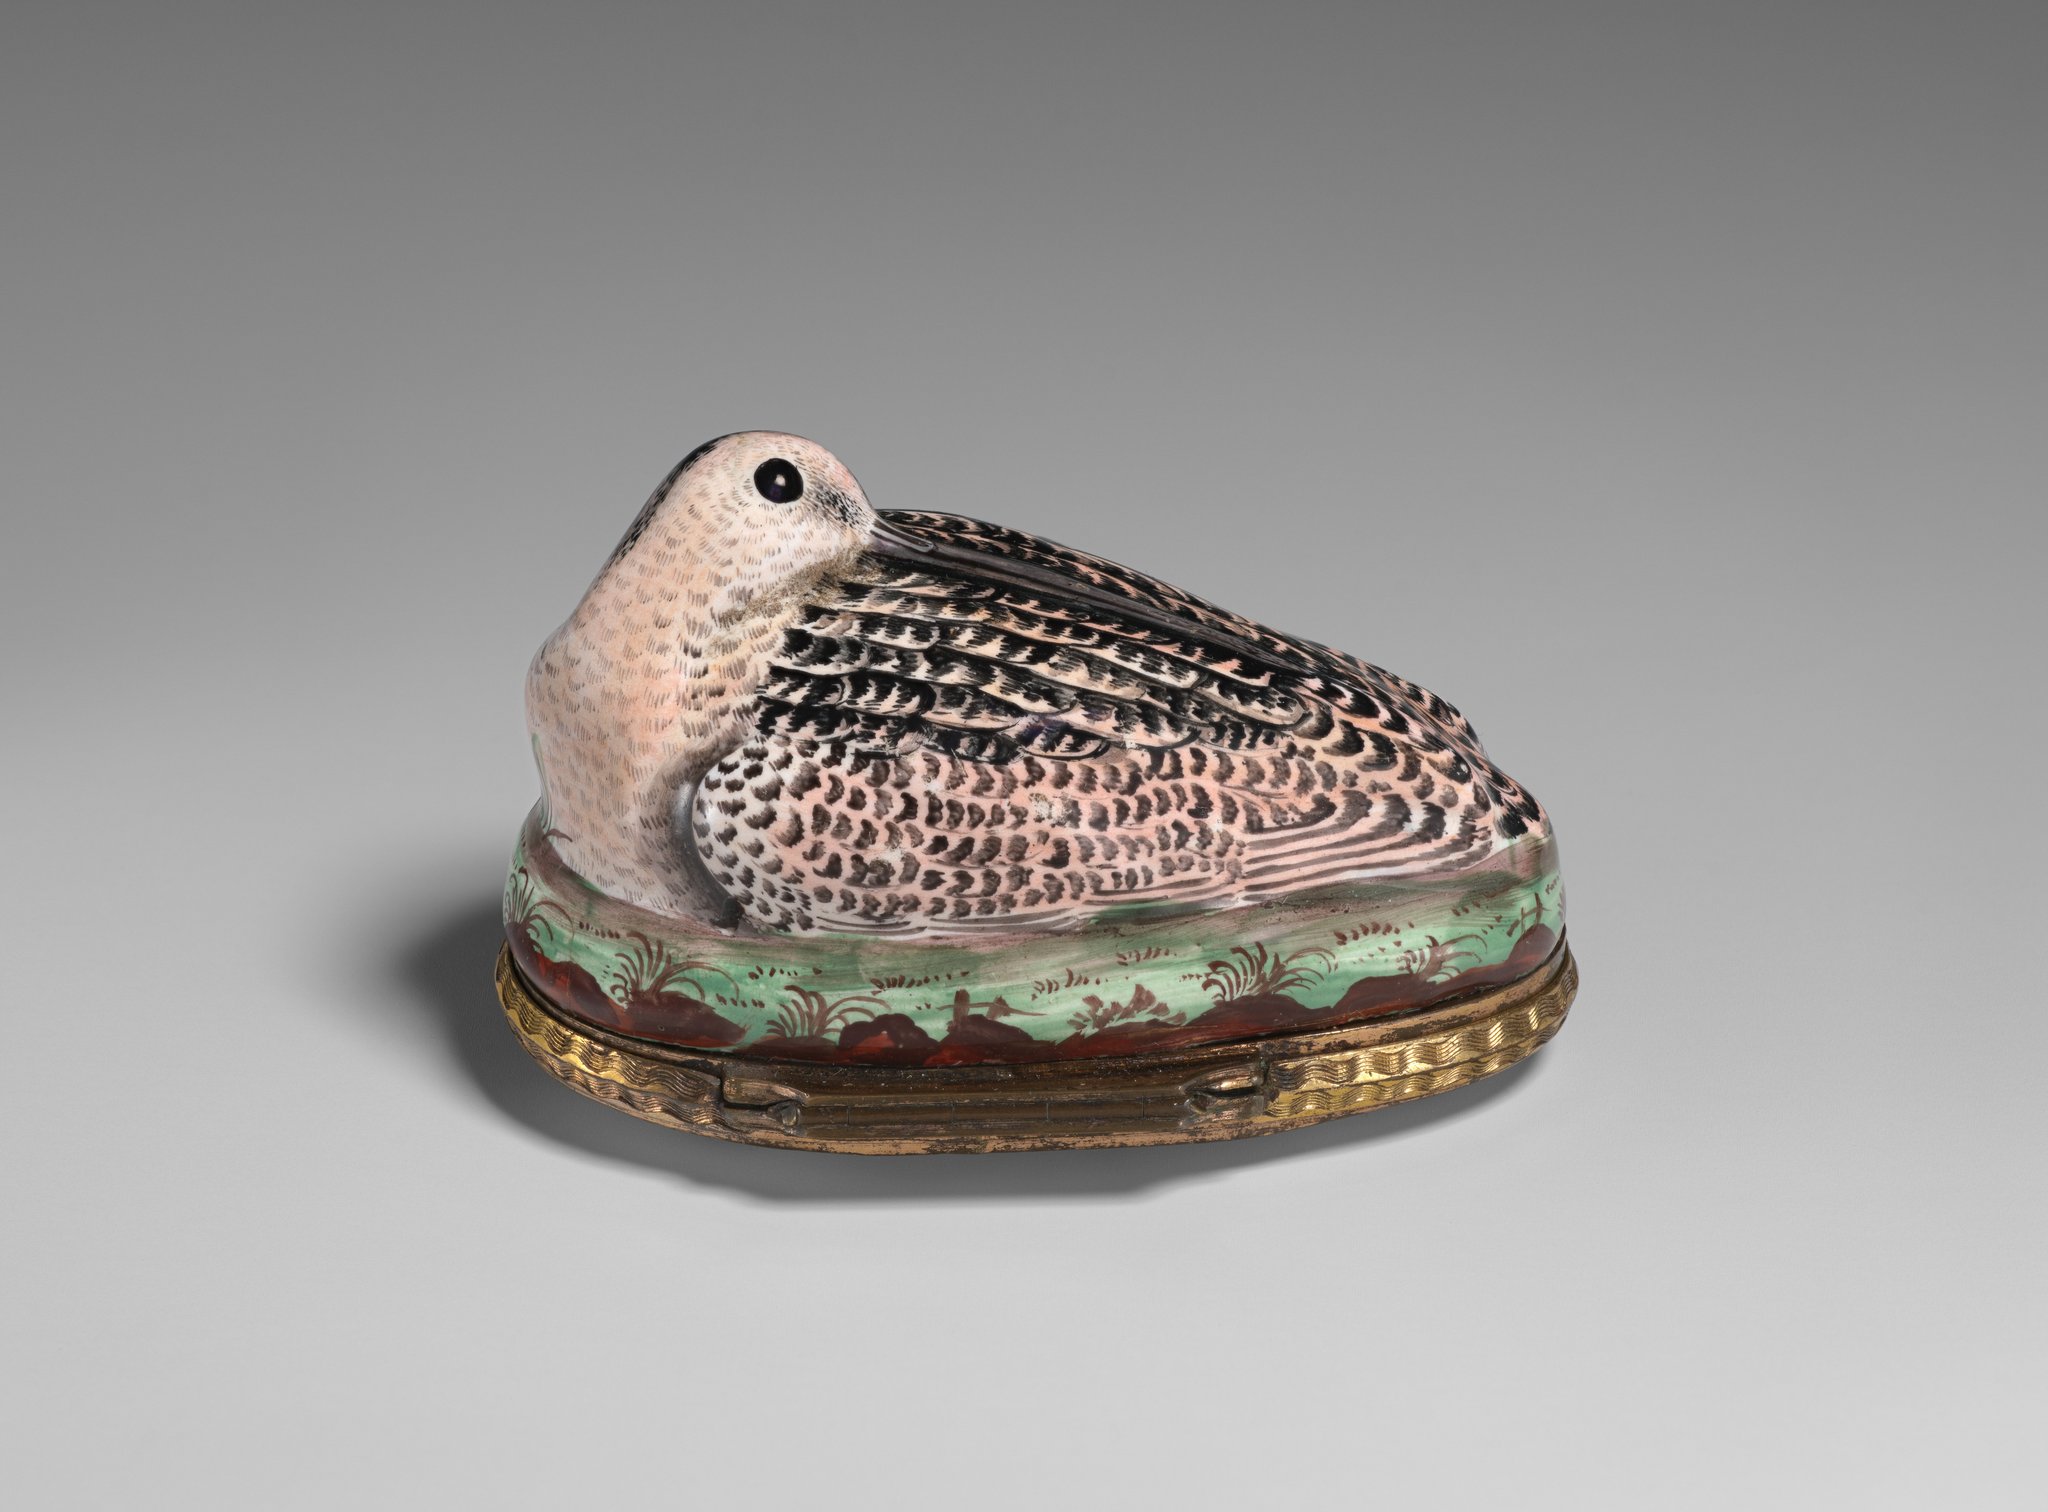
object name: bonbonnière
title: Bonbonnière in the form of a bird (snipe)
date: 1770-1780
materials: copper, enamel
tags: birds